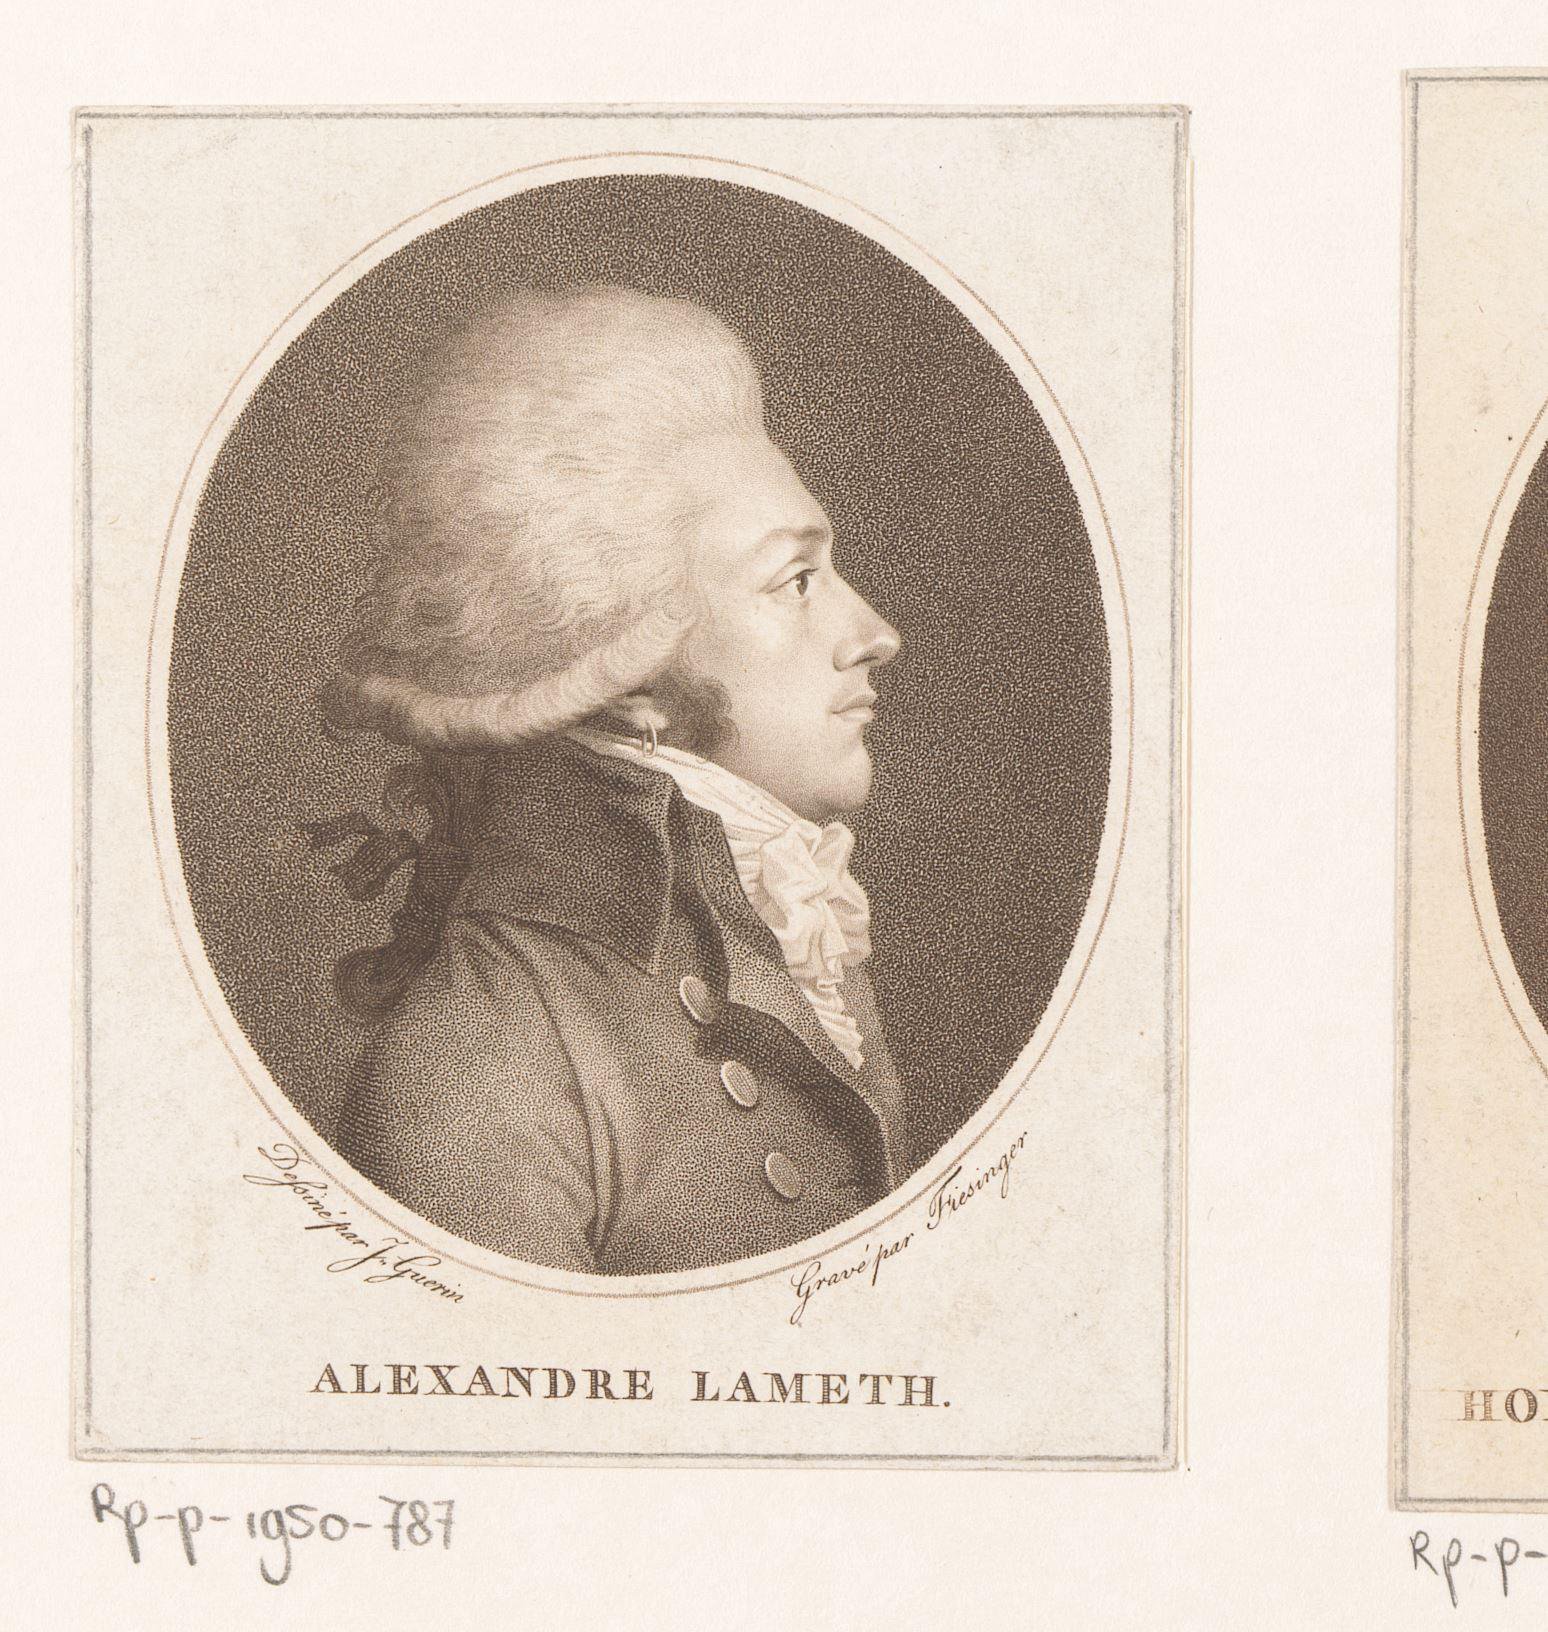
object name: print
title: Portret van Alexandre Lameth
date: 1790-1807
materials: paper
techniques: stippling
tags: politician, historical persons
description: Prent uit een serie portretten van Franse revolutionairen.